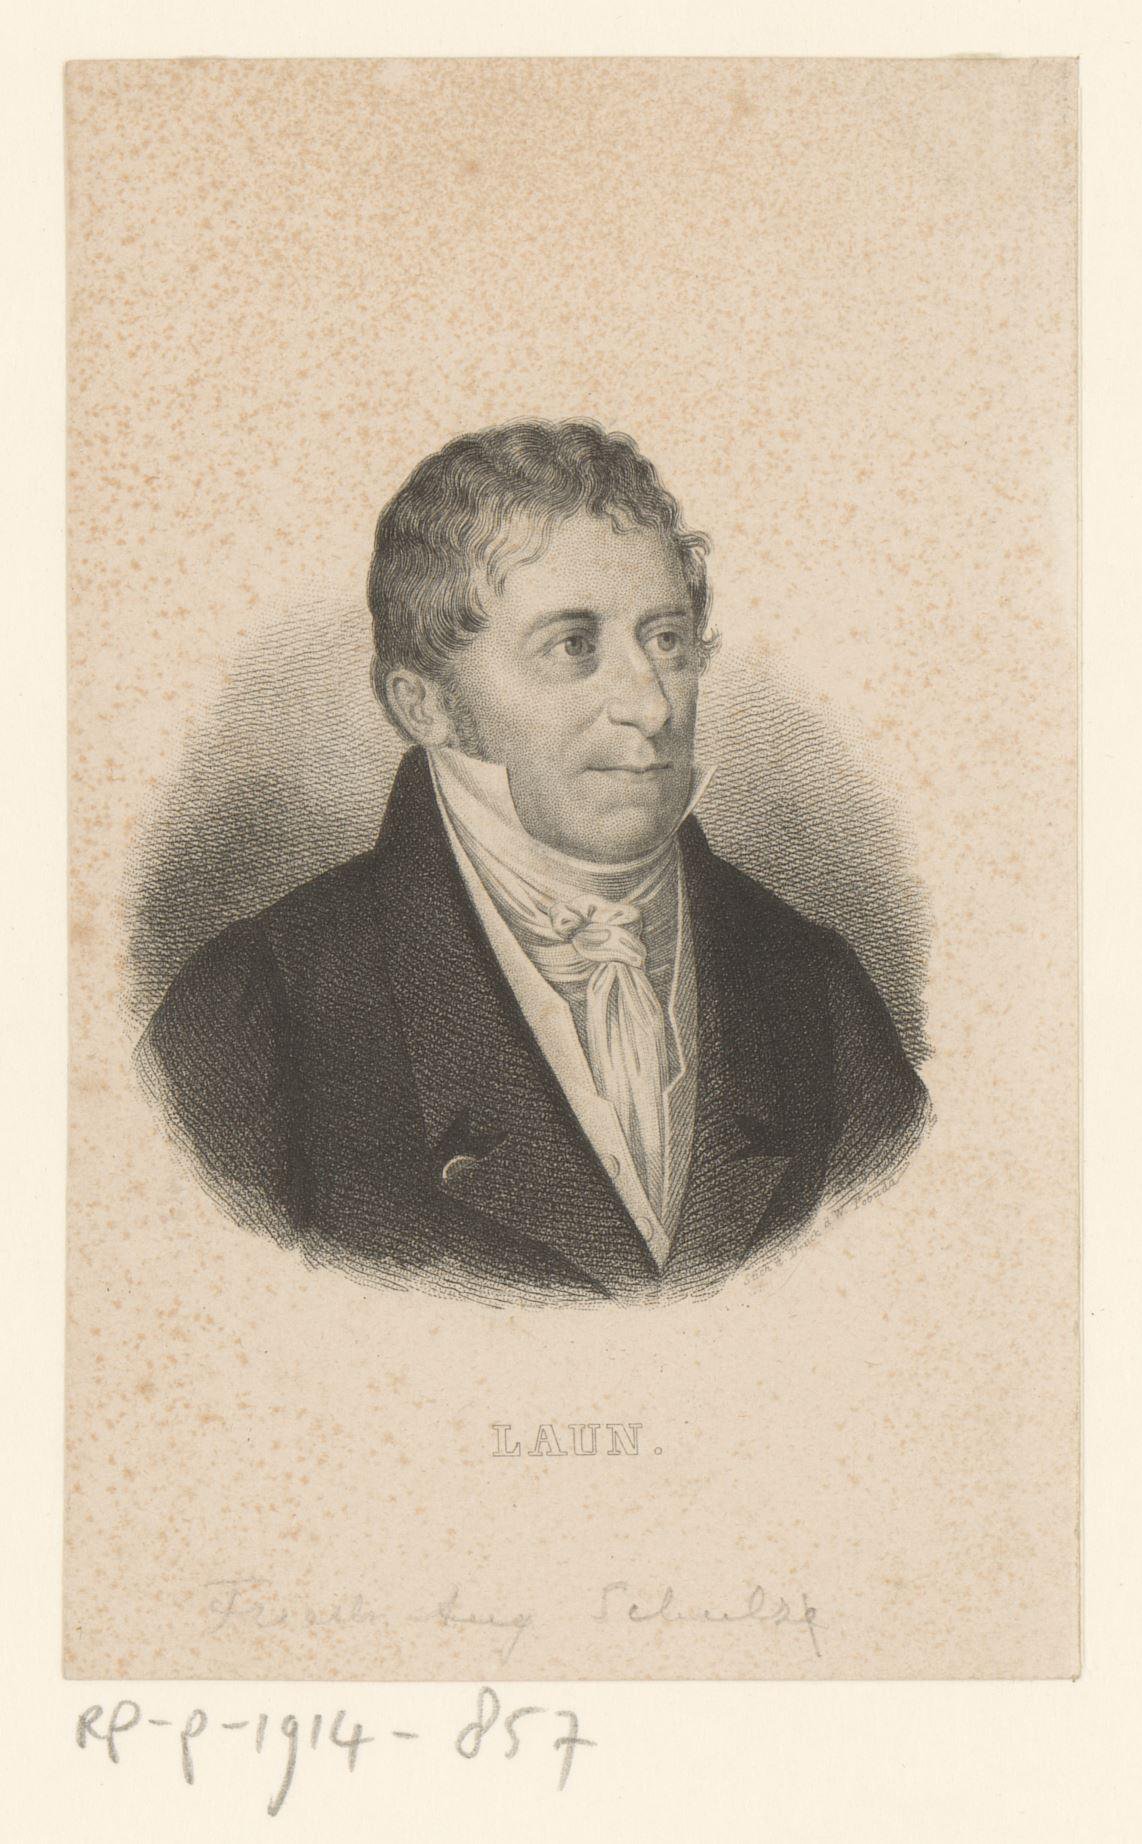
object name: print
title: Portret van Friedrich August Schulze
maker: wenzel pobuda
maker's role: print maker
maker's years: 1797-1847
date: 1807-1847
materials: paper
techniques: engraving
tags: historical persons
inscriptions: collector's mark: Lugt 2228, name